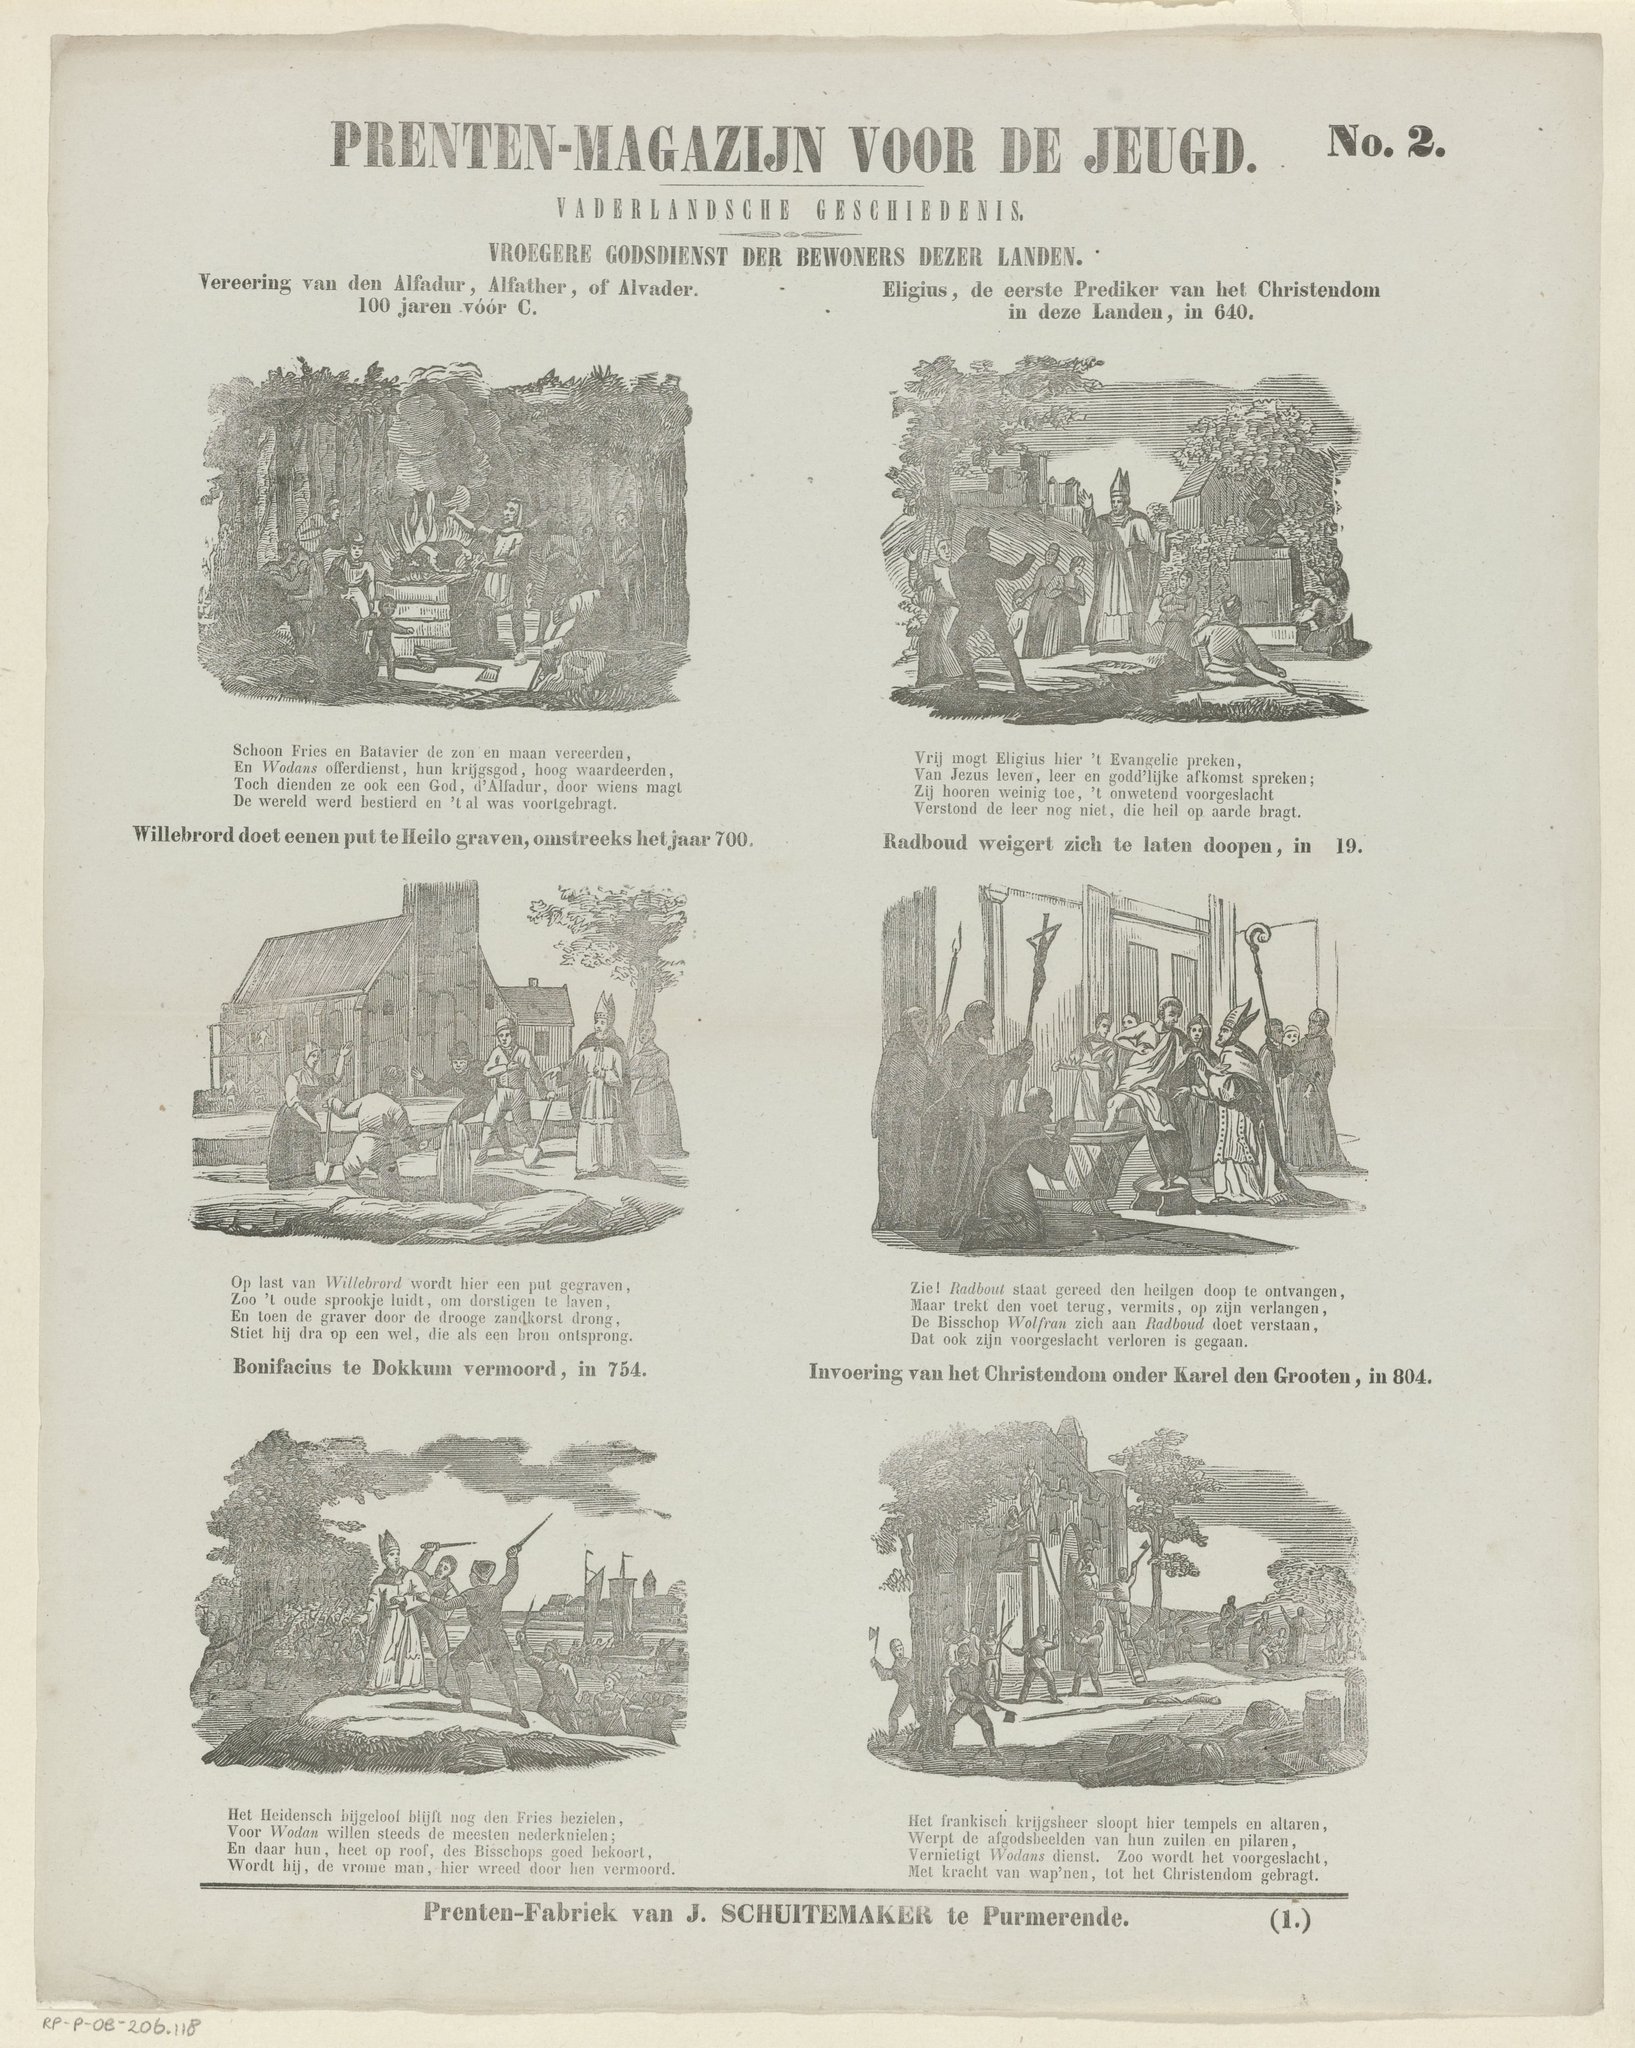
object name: popular print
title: Vroegere godsdienst der bewoners dezer landen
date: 1850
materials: paper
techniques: letterpress printing, engraving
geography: purmerend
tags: charlemagne (holy roman emperor), bishop st. eloi preaching, martyr(s) (often with palm-branches)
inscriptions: collector's mark: Lugt 2760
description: Na voltooiing van de acht jaargangen van de reeks 'Prenten-magazijn voor de jeugd' in 1850 heeft Jan Schuitemaker al deze prenten heruitgegeven en omgenummerd als nr. 1 t/m 192. De oorspronkelijke jaargang wordt telkens nog vermeld rechtsonder op de prent. Binnen de jaargangen zijn prenten van hetzelfde thema in clusters van vier achter elkaar gezet.